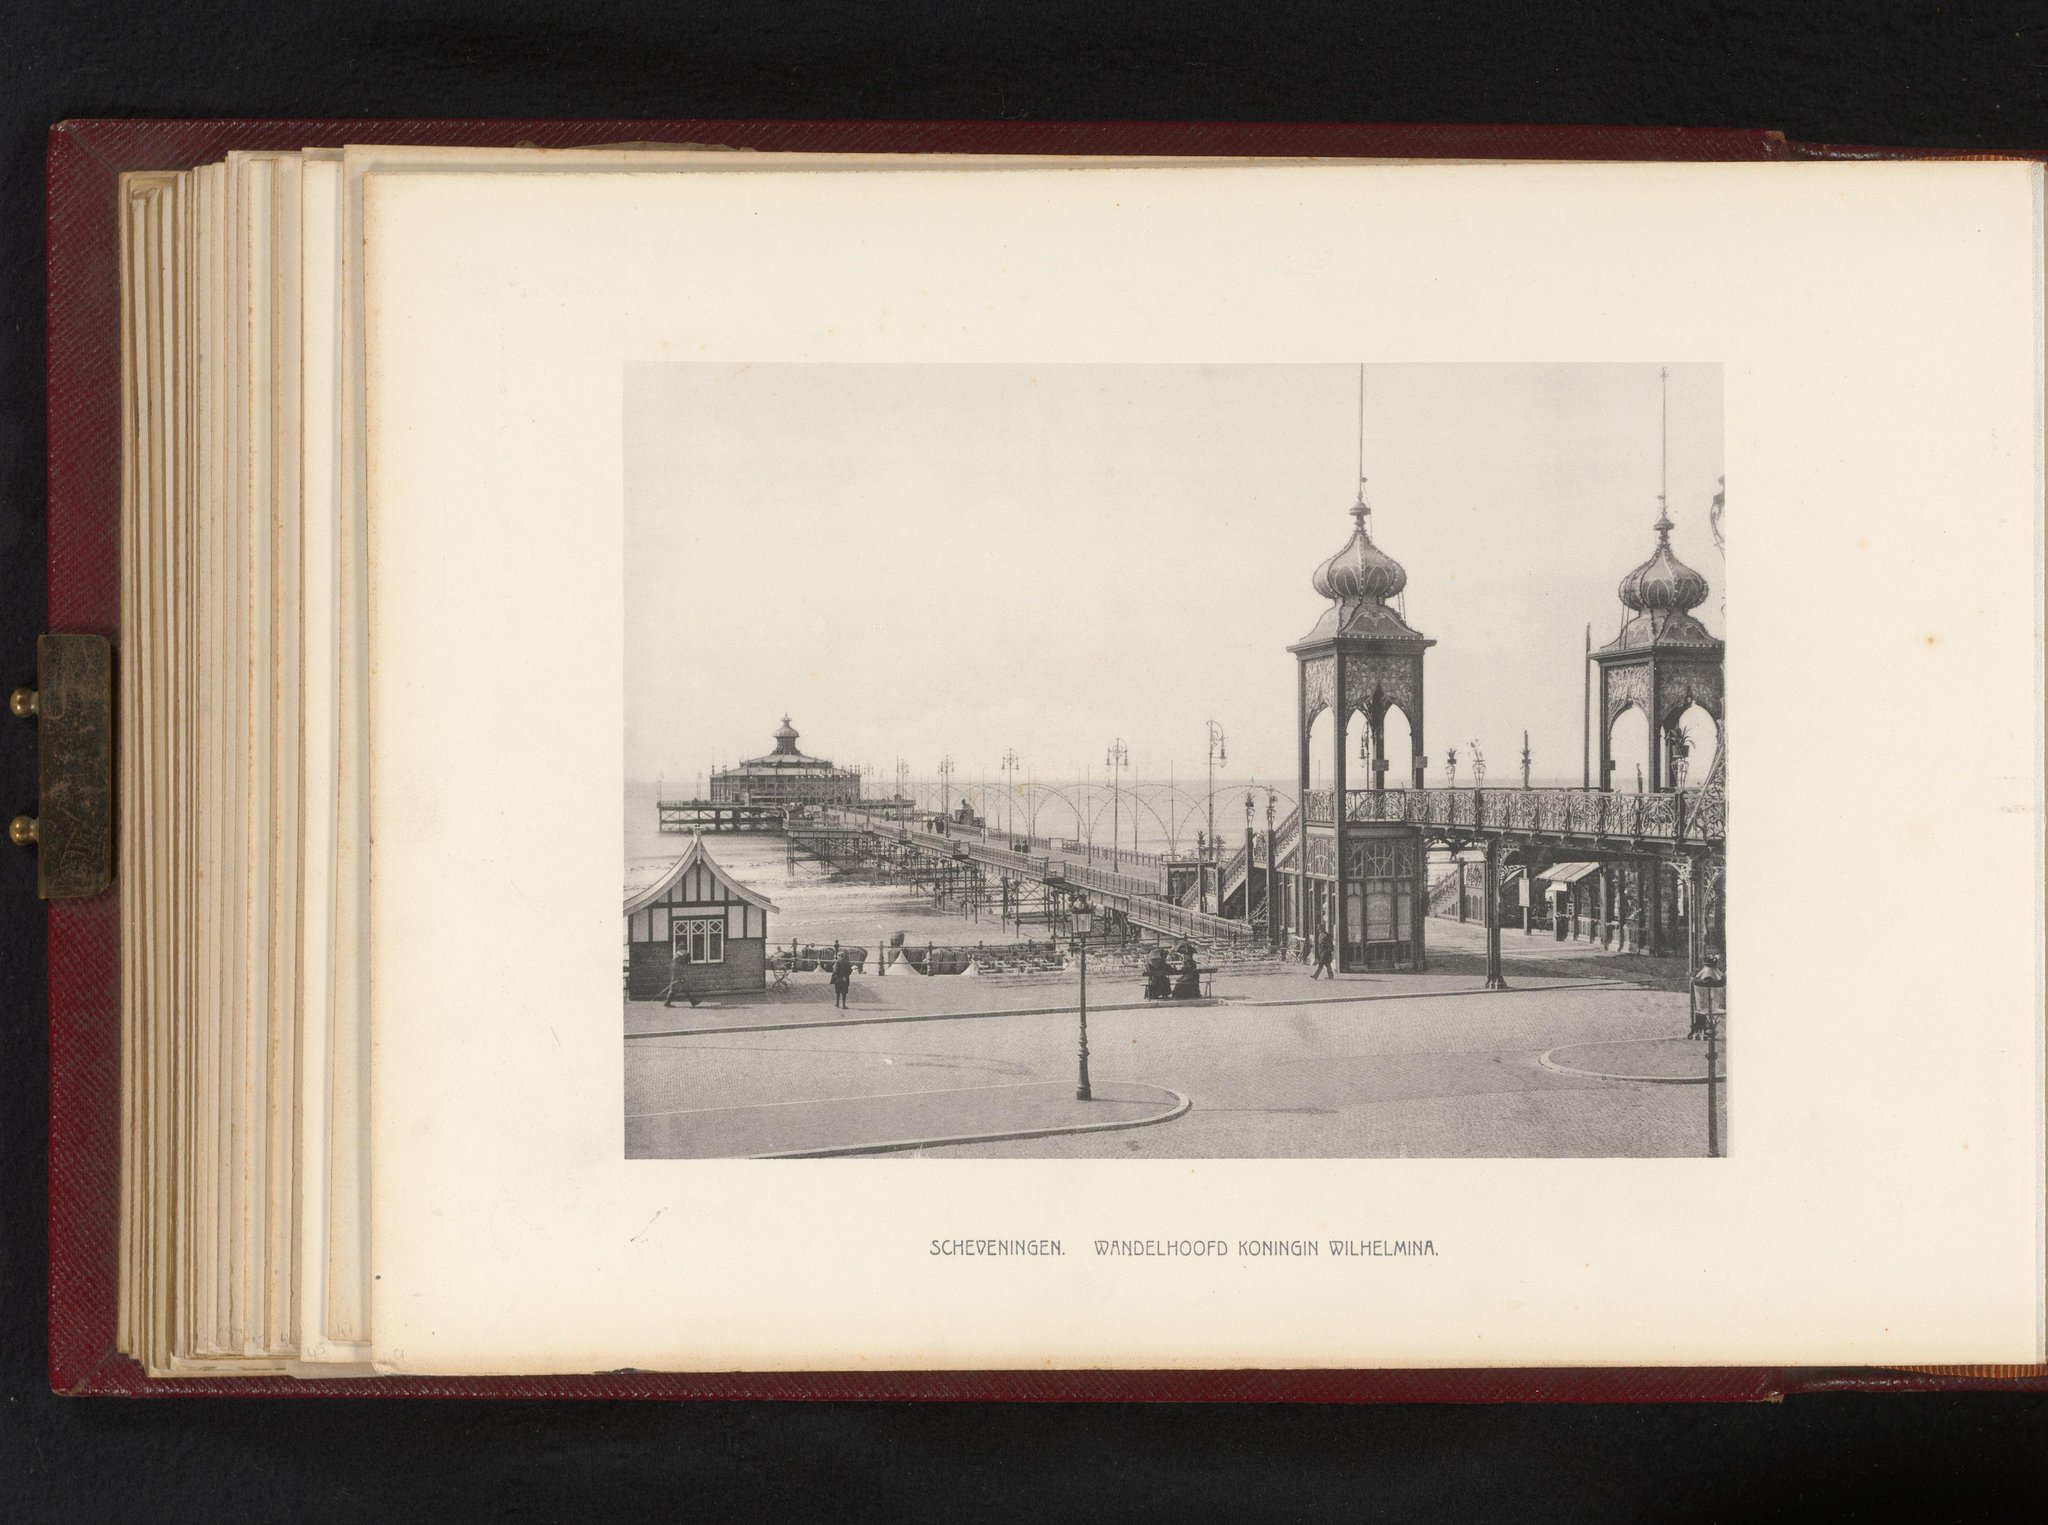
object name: photomechanical print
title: Gezicht op Wandelhoofd Koningin Wilhelmina te Scheveningen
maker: Anonymous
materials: paper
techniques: photograph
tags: historical persons, pier, quay, wharf, sea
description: Deze pagina maakt deel uit van een album.